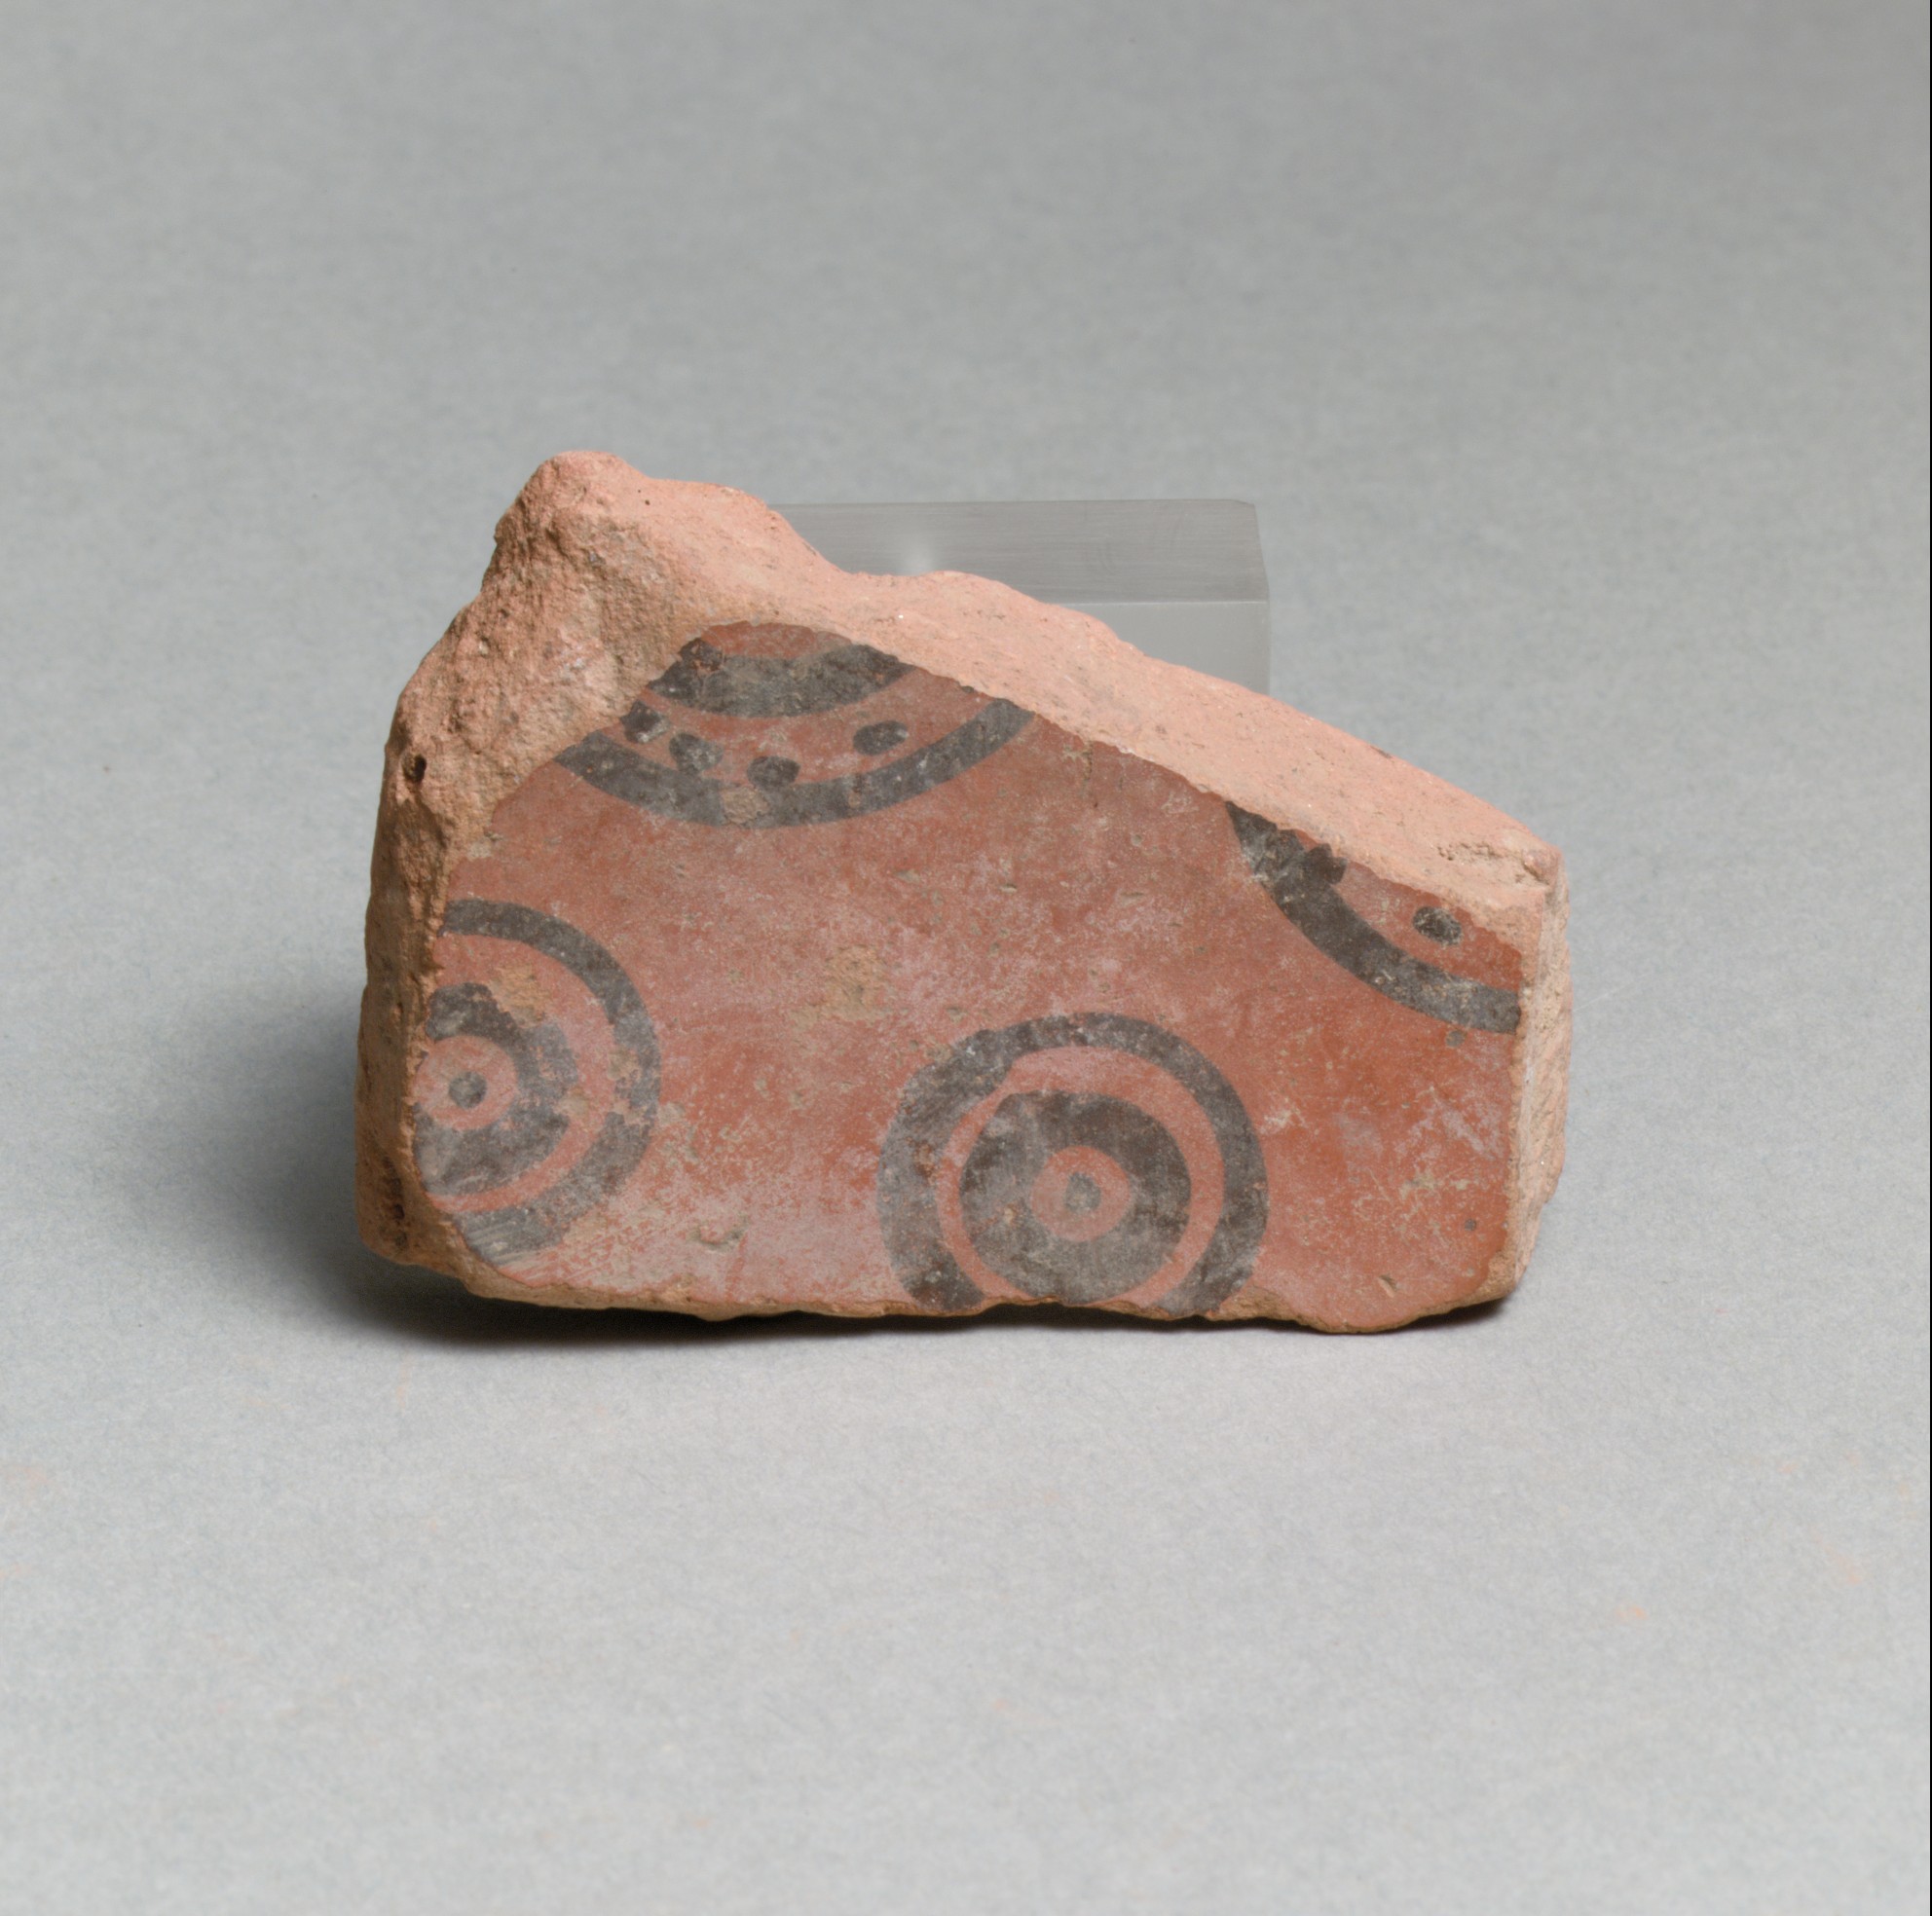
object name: vase fragment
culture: greek or lydian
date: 1050-700 BCE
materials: terracotta